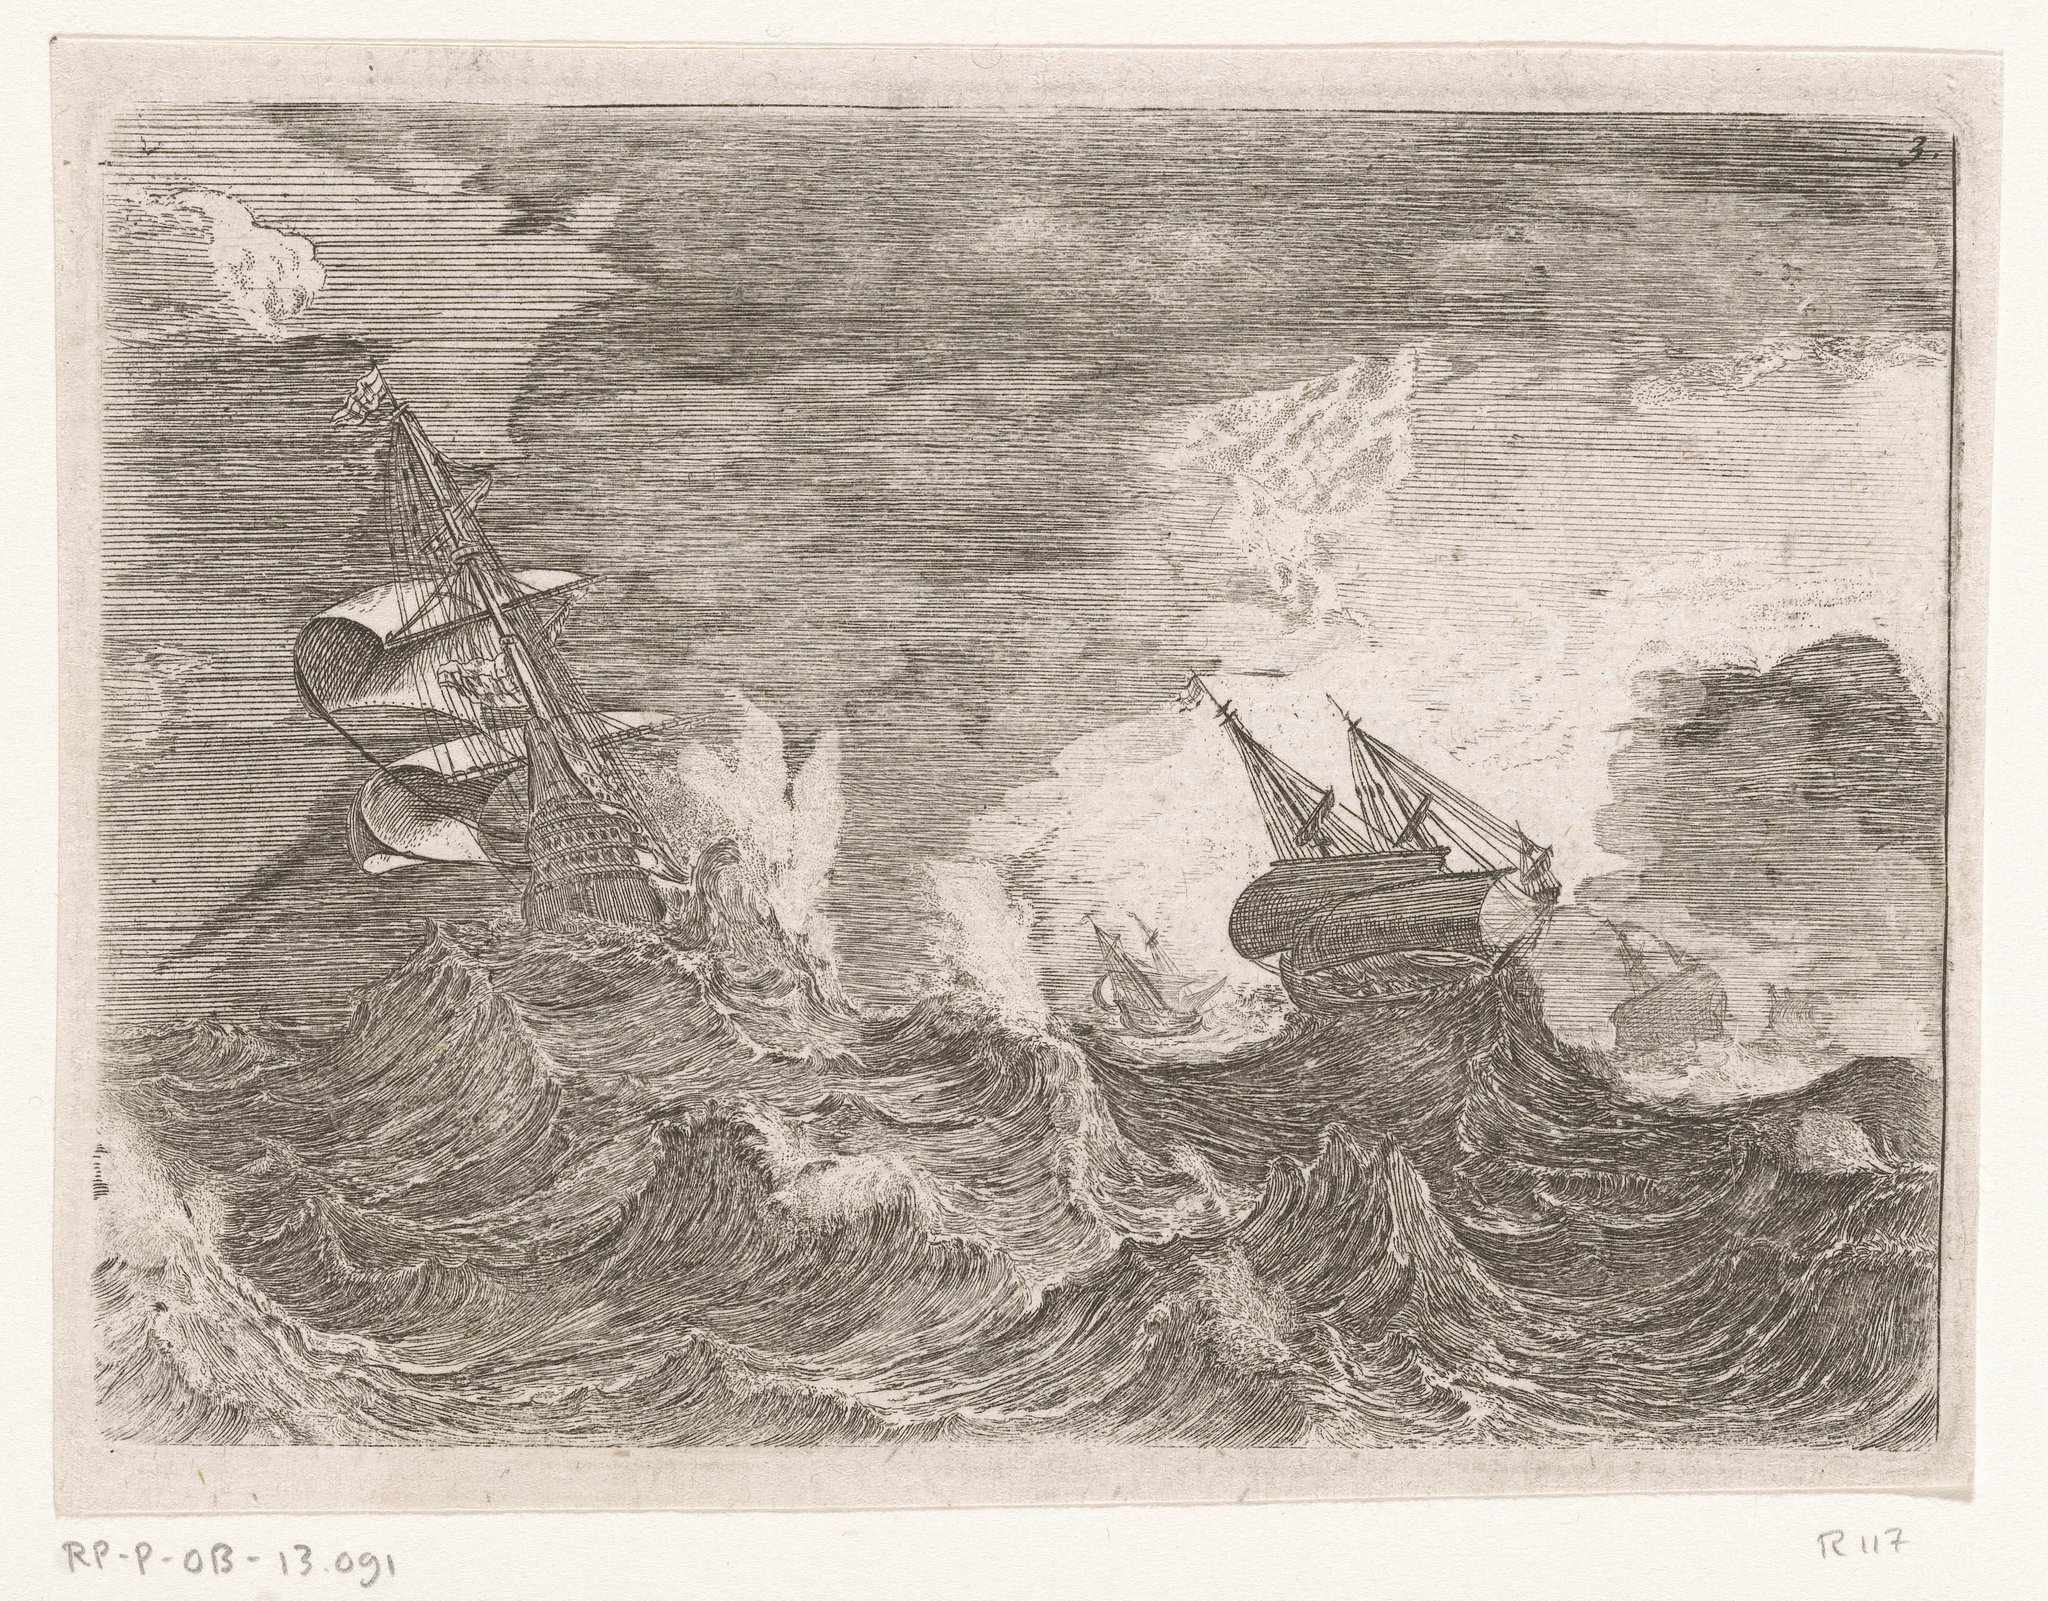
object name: print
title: Vijf zeilschepen op zee tijdens een storm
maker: johann wilhelm baur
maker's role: draughtsman, painter, print maker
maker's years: 1607-1642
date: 1640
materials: paper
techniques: etching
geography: vienna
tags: sailing-ship, sailing-boat, storm at sea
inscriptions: collector's mark: Lugt 2228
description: Derde prent uit de serie 'Schepen in stormachtig weer', bestaand uit vier genummerde prenten. Van deze serie bestaan ook latere drukken, uitgegeven te Augsburg door Joachim Wolf en de erven van Johann Michael Probst.